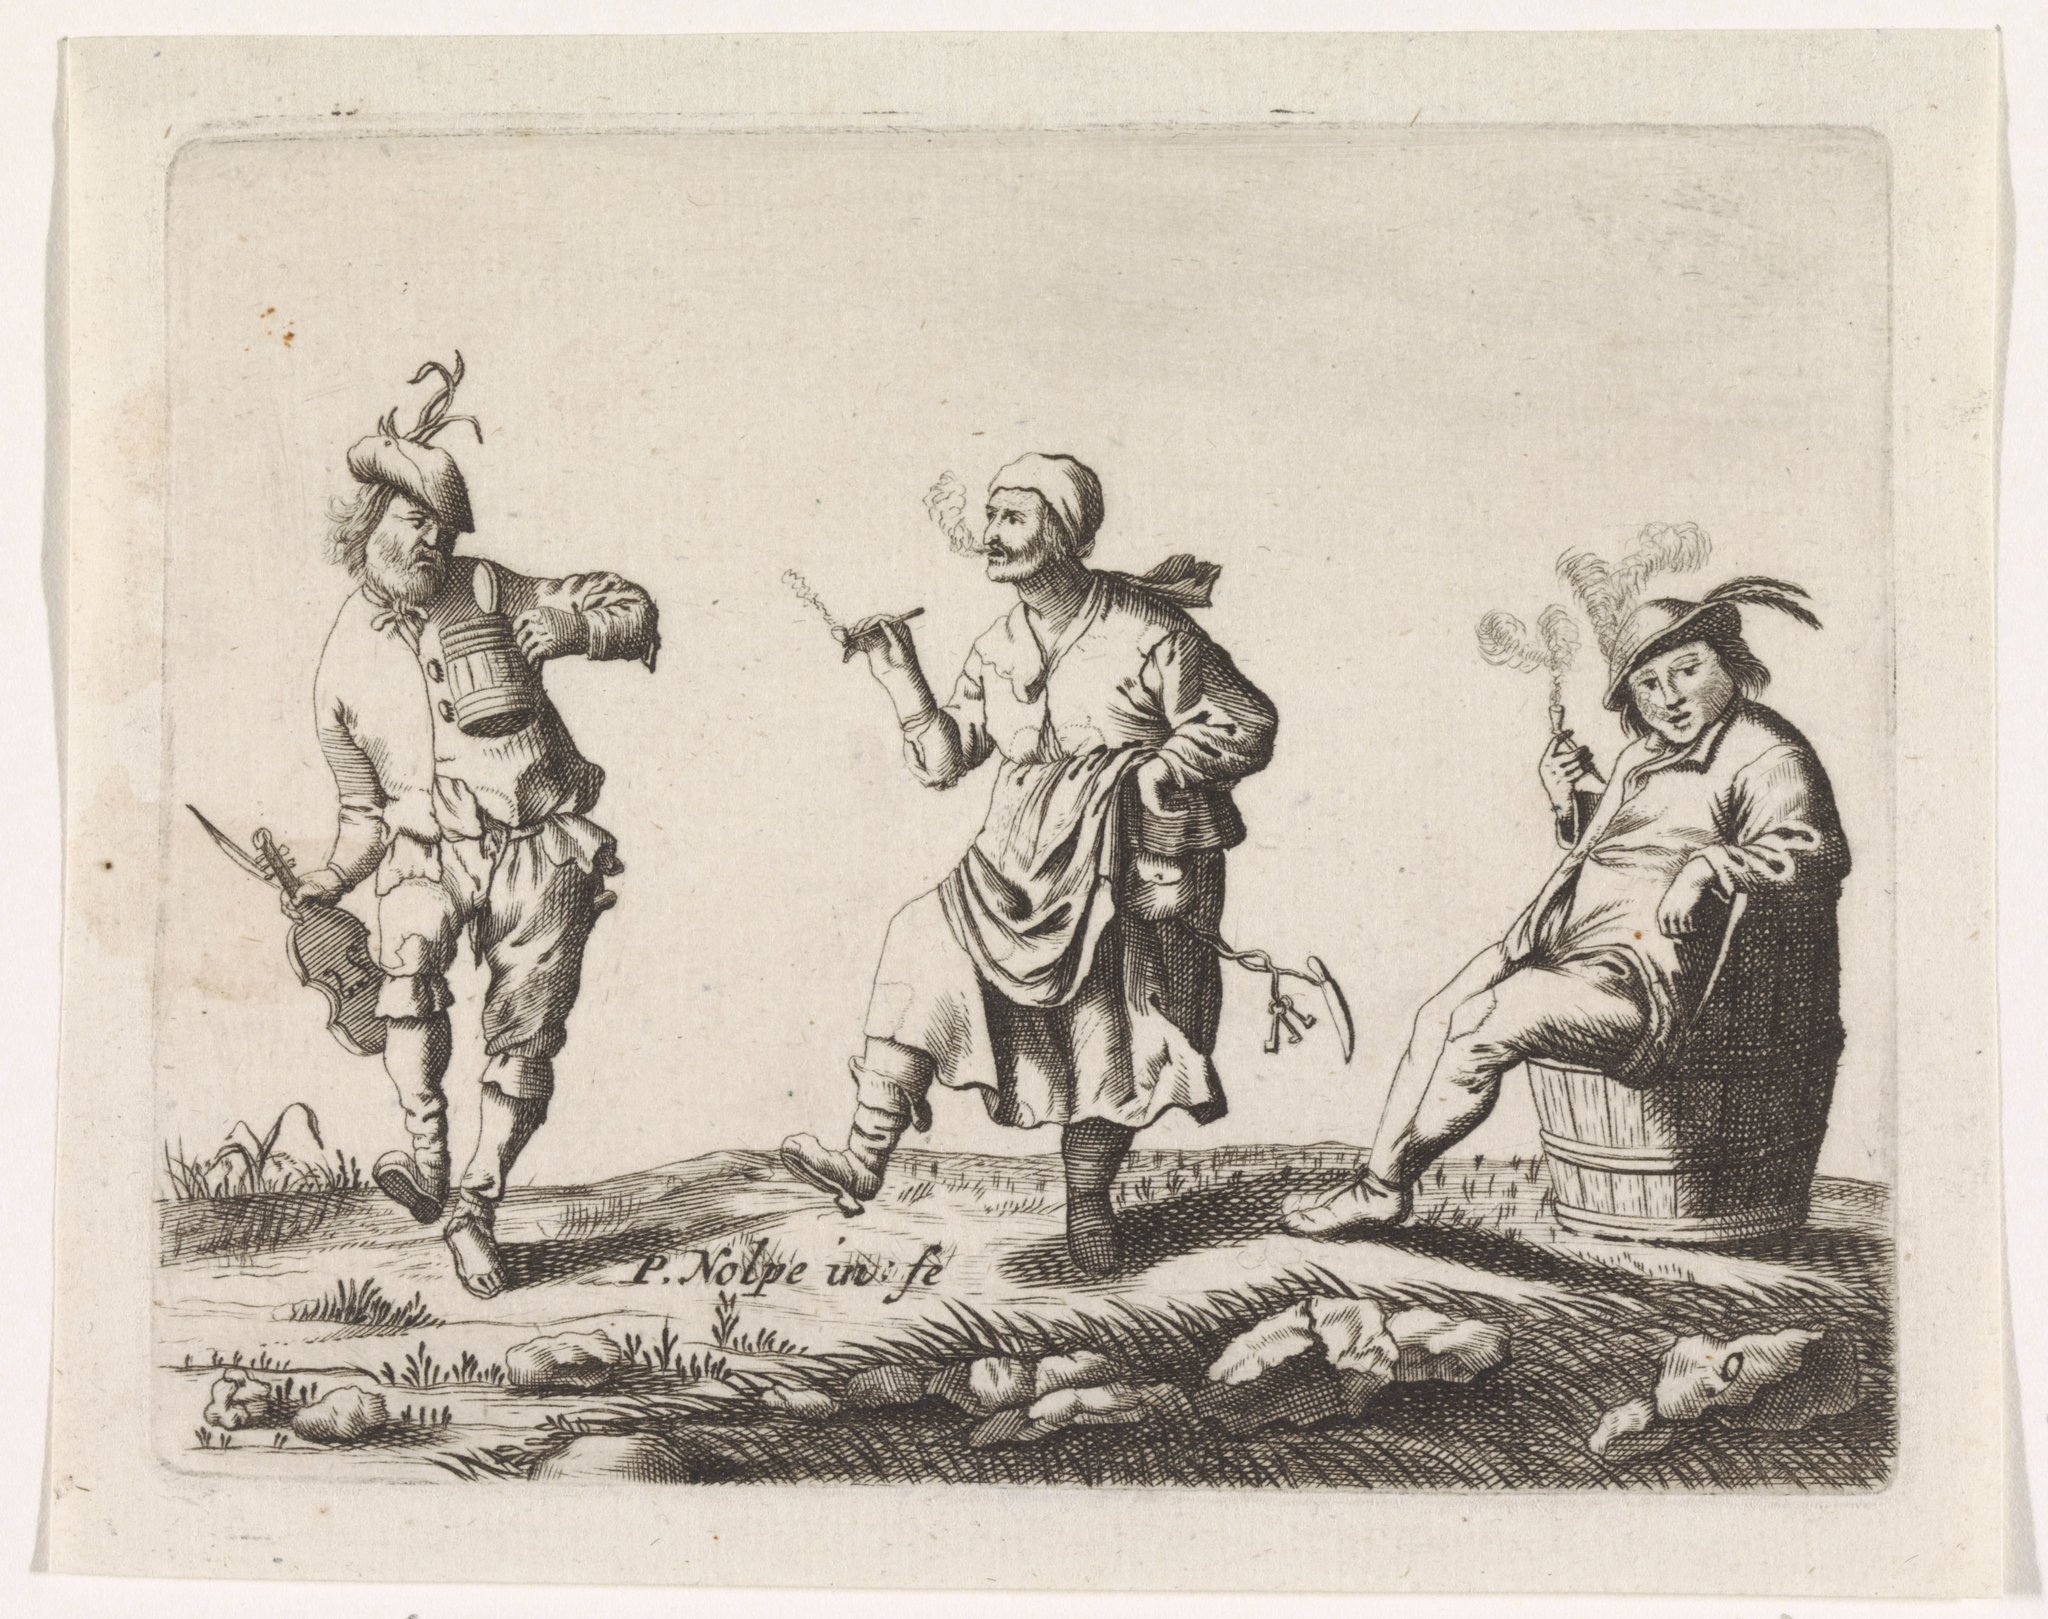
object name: print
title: Dansende boer en boerin en een man op een ton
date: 1623-1703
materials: paper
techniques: engraving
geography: amsterdam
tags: wooden container: barrel, cask, bucket, dancing, violin, fiddle, pipe ~ tobacco, farmers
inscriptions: collector's mark: Lugt 2228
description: Een boer en een boerin dansen naast elkaar in het gras. De boer houdt een drinkbeker in de ene en een viool in de andere hand.De boerin rookt een pijpje en heeft een sleutelbos en een mes aan haar kleed hangen. Rechts zit een man op een als stoel gebruikte ton.